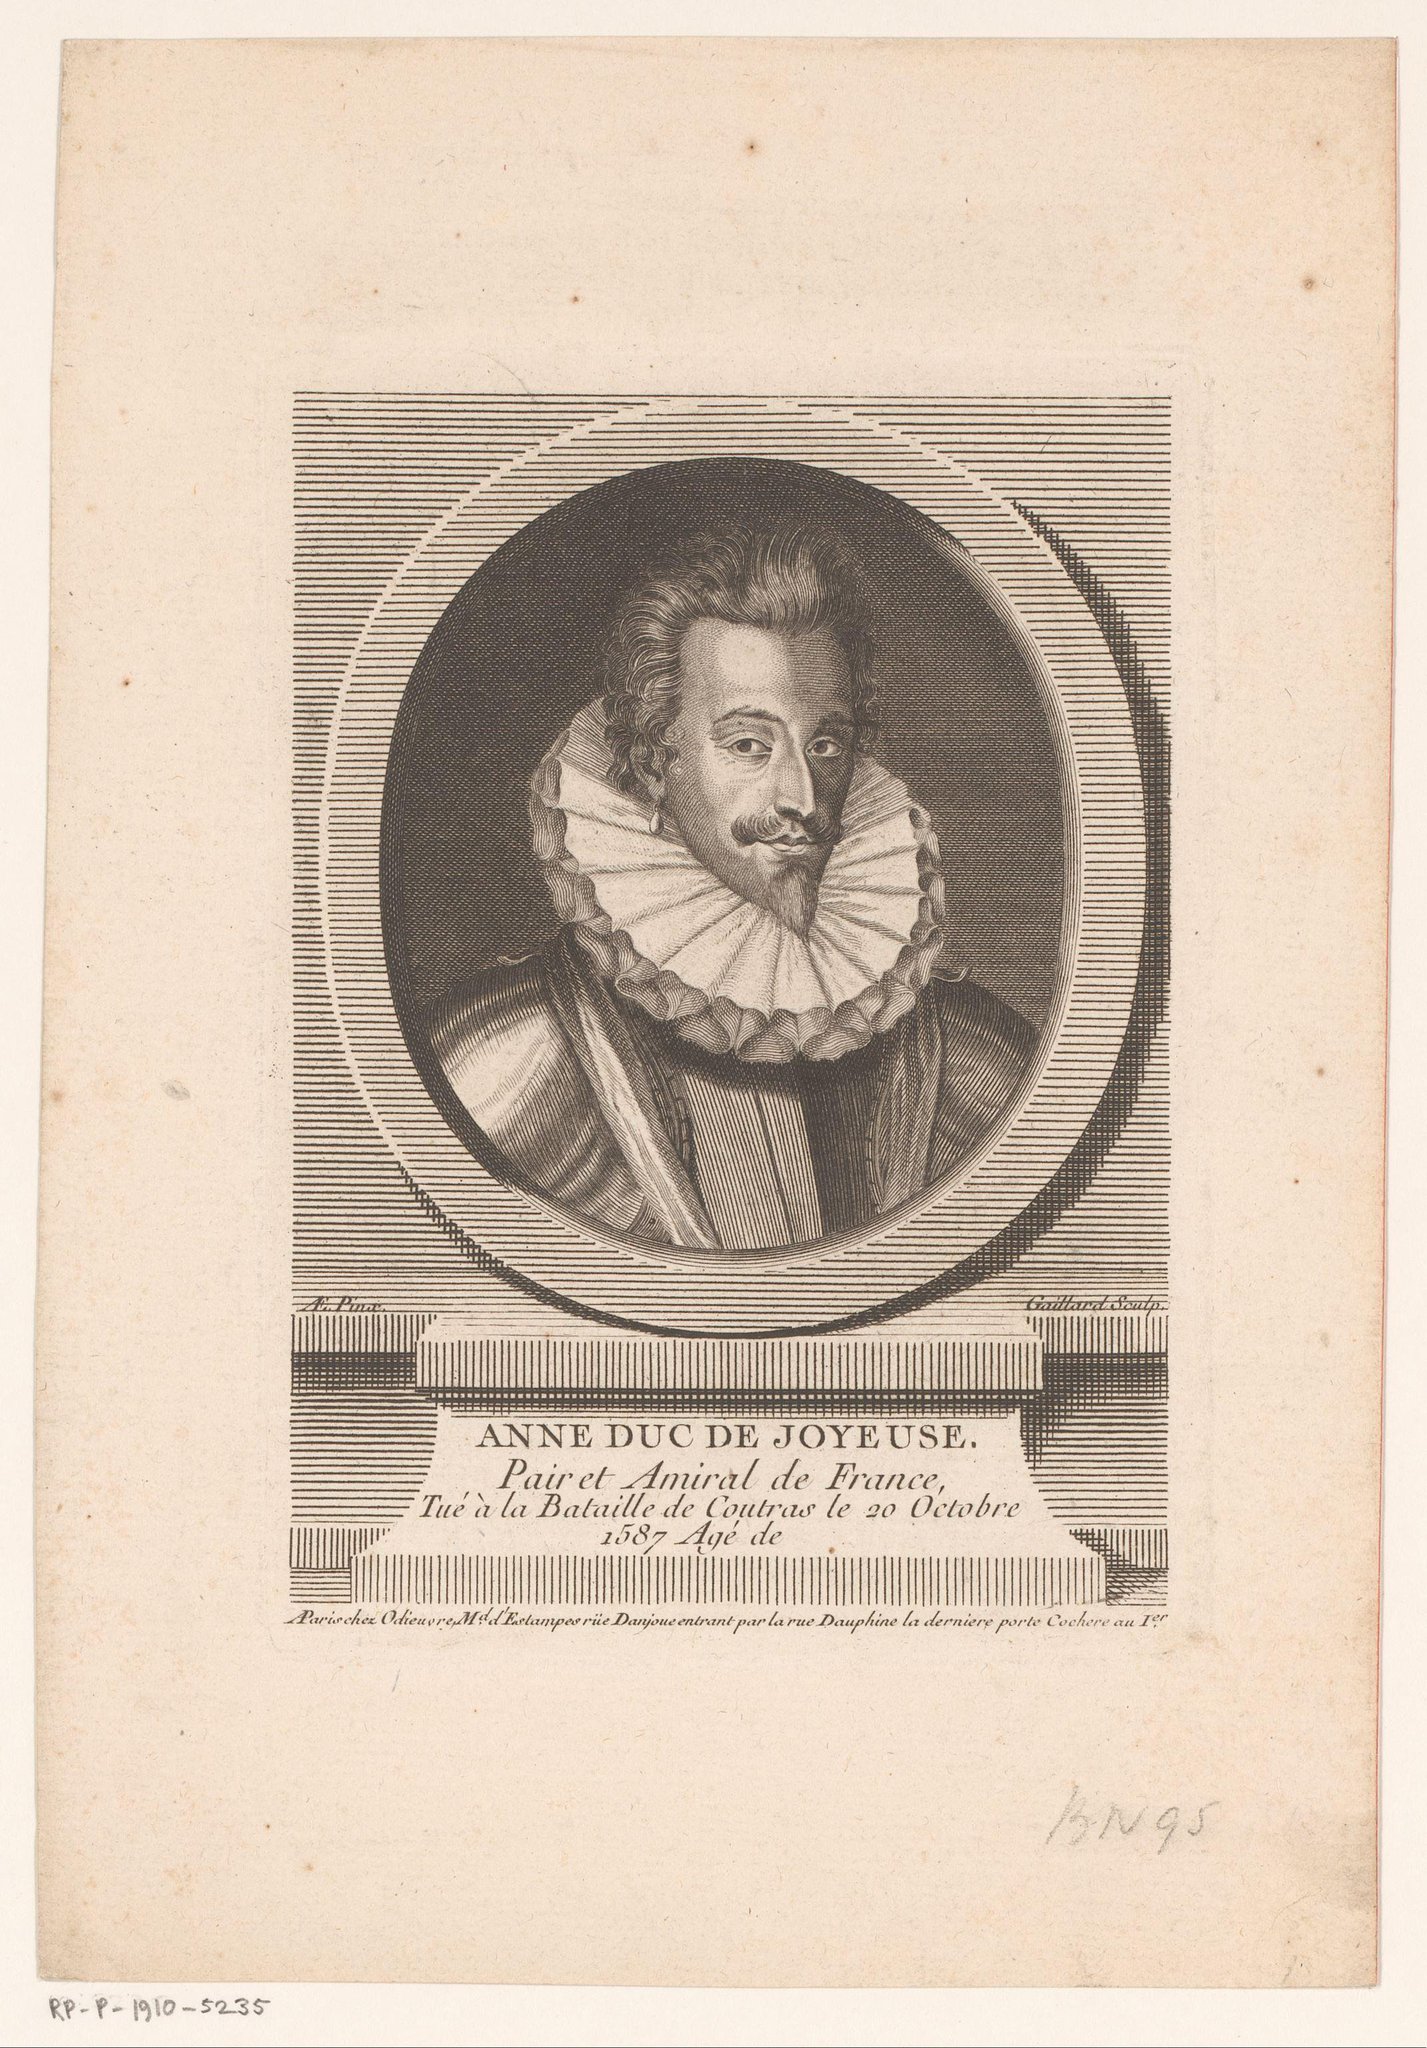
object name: print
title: Portret van Anne de Joyeuse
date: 1755-1765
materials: paper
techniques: engraving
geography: paris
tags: historical persons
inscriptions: collector's mark: Lugt 2228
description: Mogelijk prent uit: Dreux du Radier, Jean-François. L'Europe illustré, contenant l'histoire abregée des souverains, des princes, des prélats, des ministres, (...) en Europe: dans le XVe. siècle compris, jusqu'à présent. Parijs: Michel Odieuvre en André-François Le Breton, 1755-1765, dl. 3.